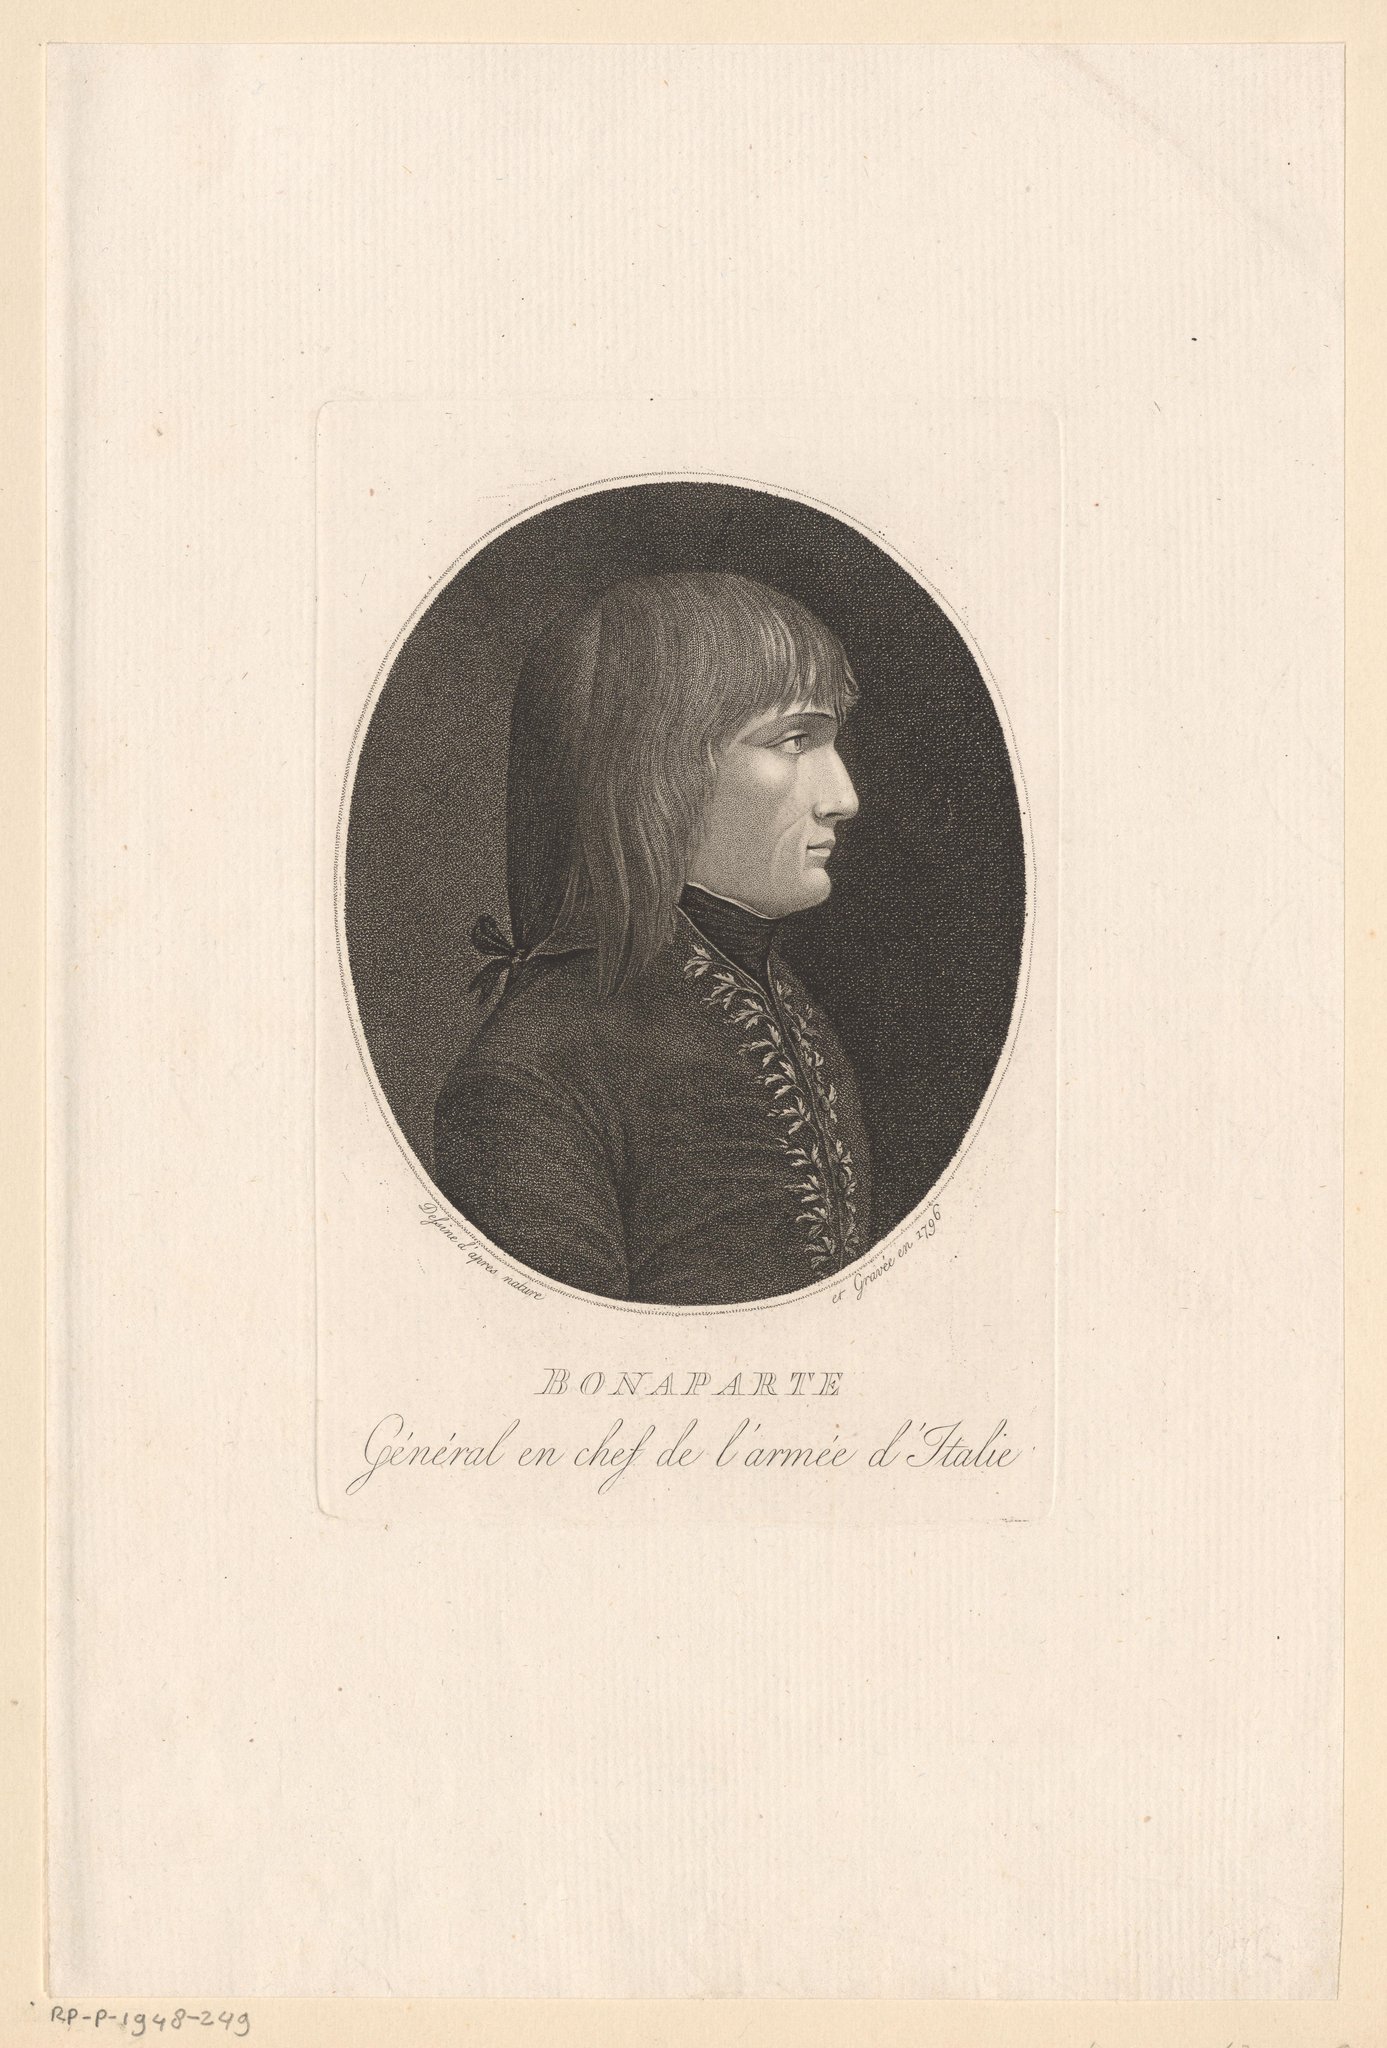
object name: print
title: Portret van Napoleon I Bonaparte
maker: Anonymous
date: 1796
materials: paper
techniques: engraving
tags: napoleon i (emperor of the french), commander-in-chief, general, marshal, historical persons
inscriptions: collector's mark: Lugt 2228